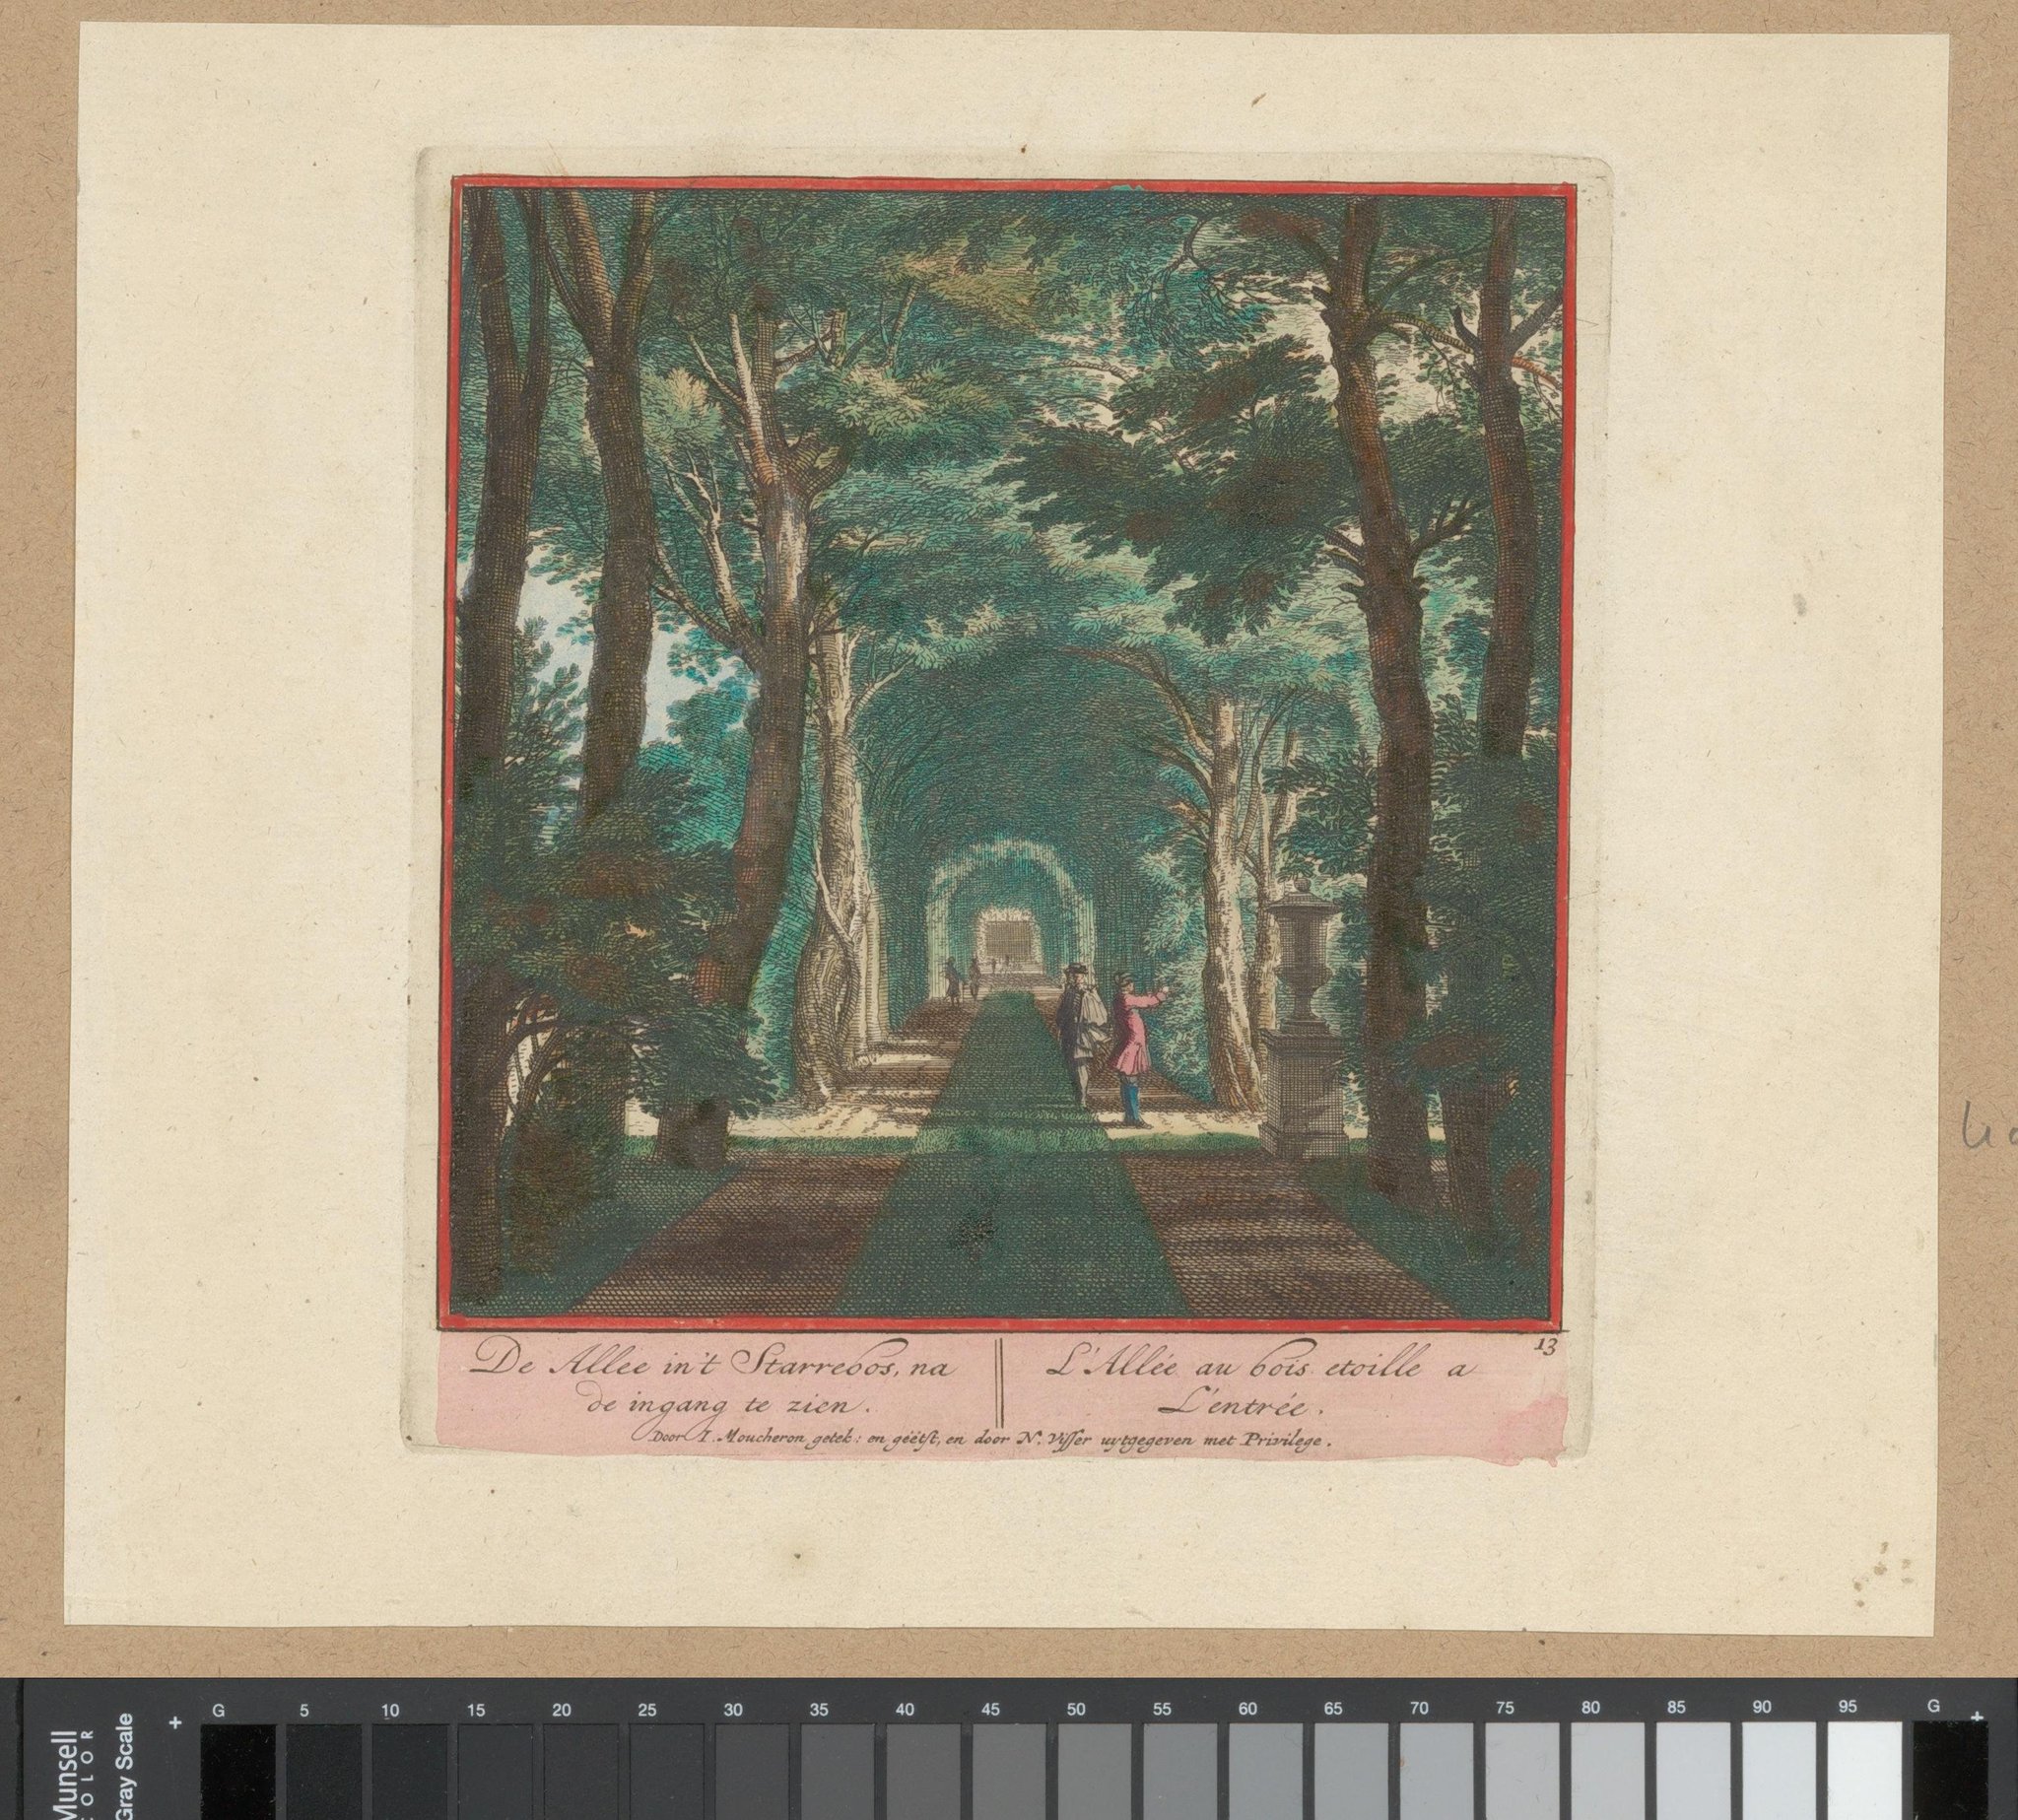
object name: print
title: Overdekt pad gezien naar de ingang van Kasteel Heemstede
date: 1706-1719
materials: paper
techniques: engraving, etching, hand coloring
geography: amsterdam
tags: french or architectonic garden; formal garden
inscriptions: stamp, stamp, collector's mark: Lugt 1641, stamp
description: Een door bomen overdekt pad op het landgoed van Kasteel Heemstede. Aan het einde ligt de ingang. Rechtsonder genummerd: 13. Onderwerpsrubrieken binnen de Atlas Zeden en Gewoonten: Zeden en Gewoonten in Engeren Zin, De Woning, Oude Nederlandsche Tuinkunst, De 17de en 18de eeuw. Stadtuinen.